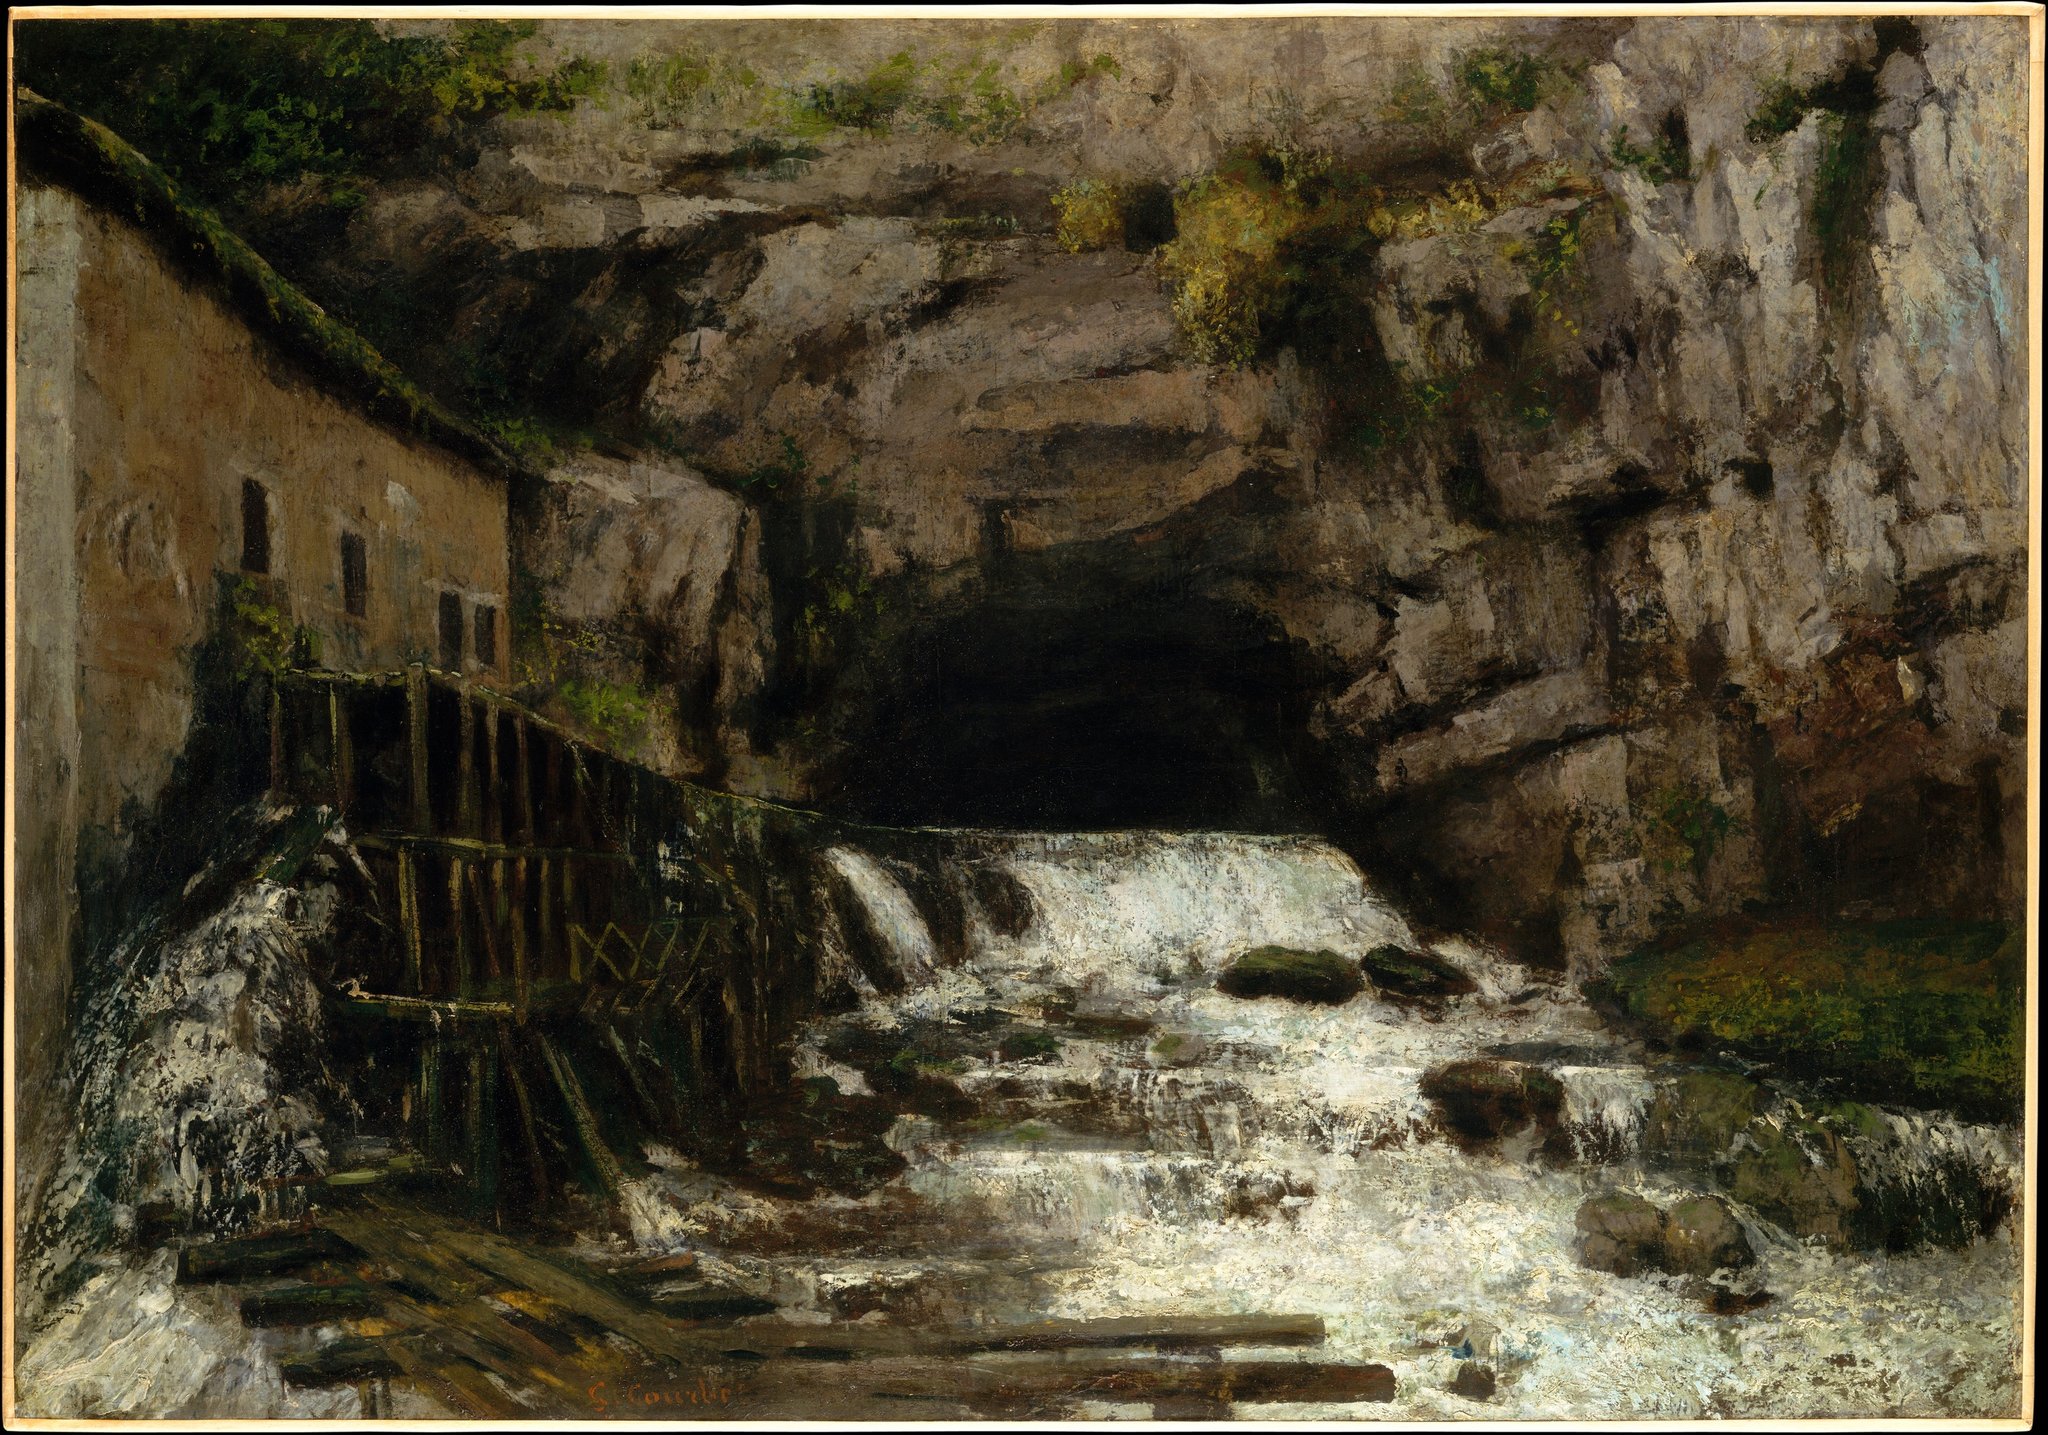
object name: painting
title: The Source of the Loue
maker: gustave courbet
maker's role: artist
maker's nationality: french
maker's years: 1819-1877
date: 1864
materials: canvas, oil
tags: rivers